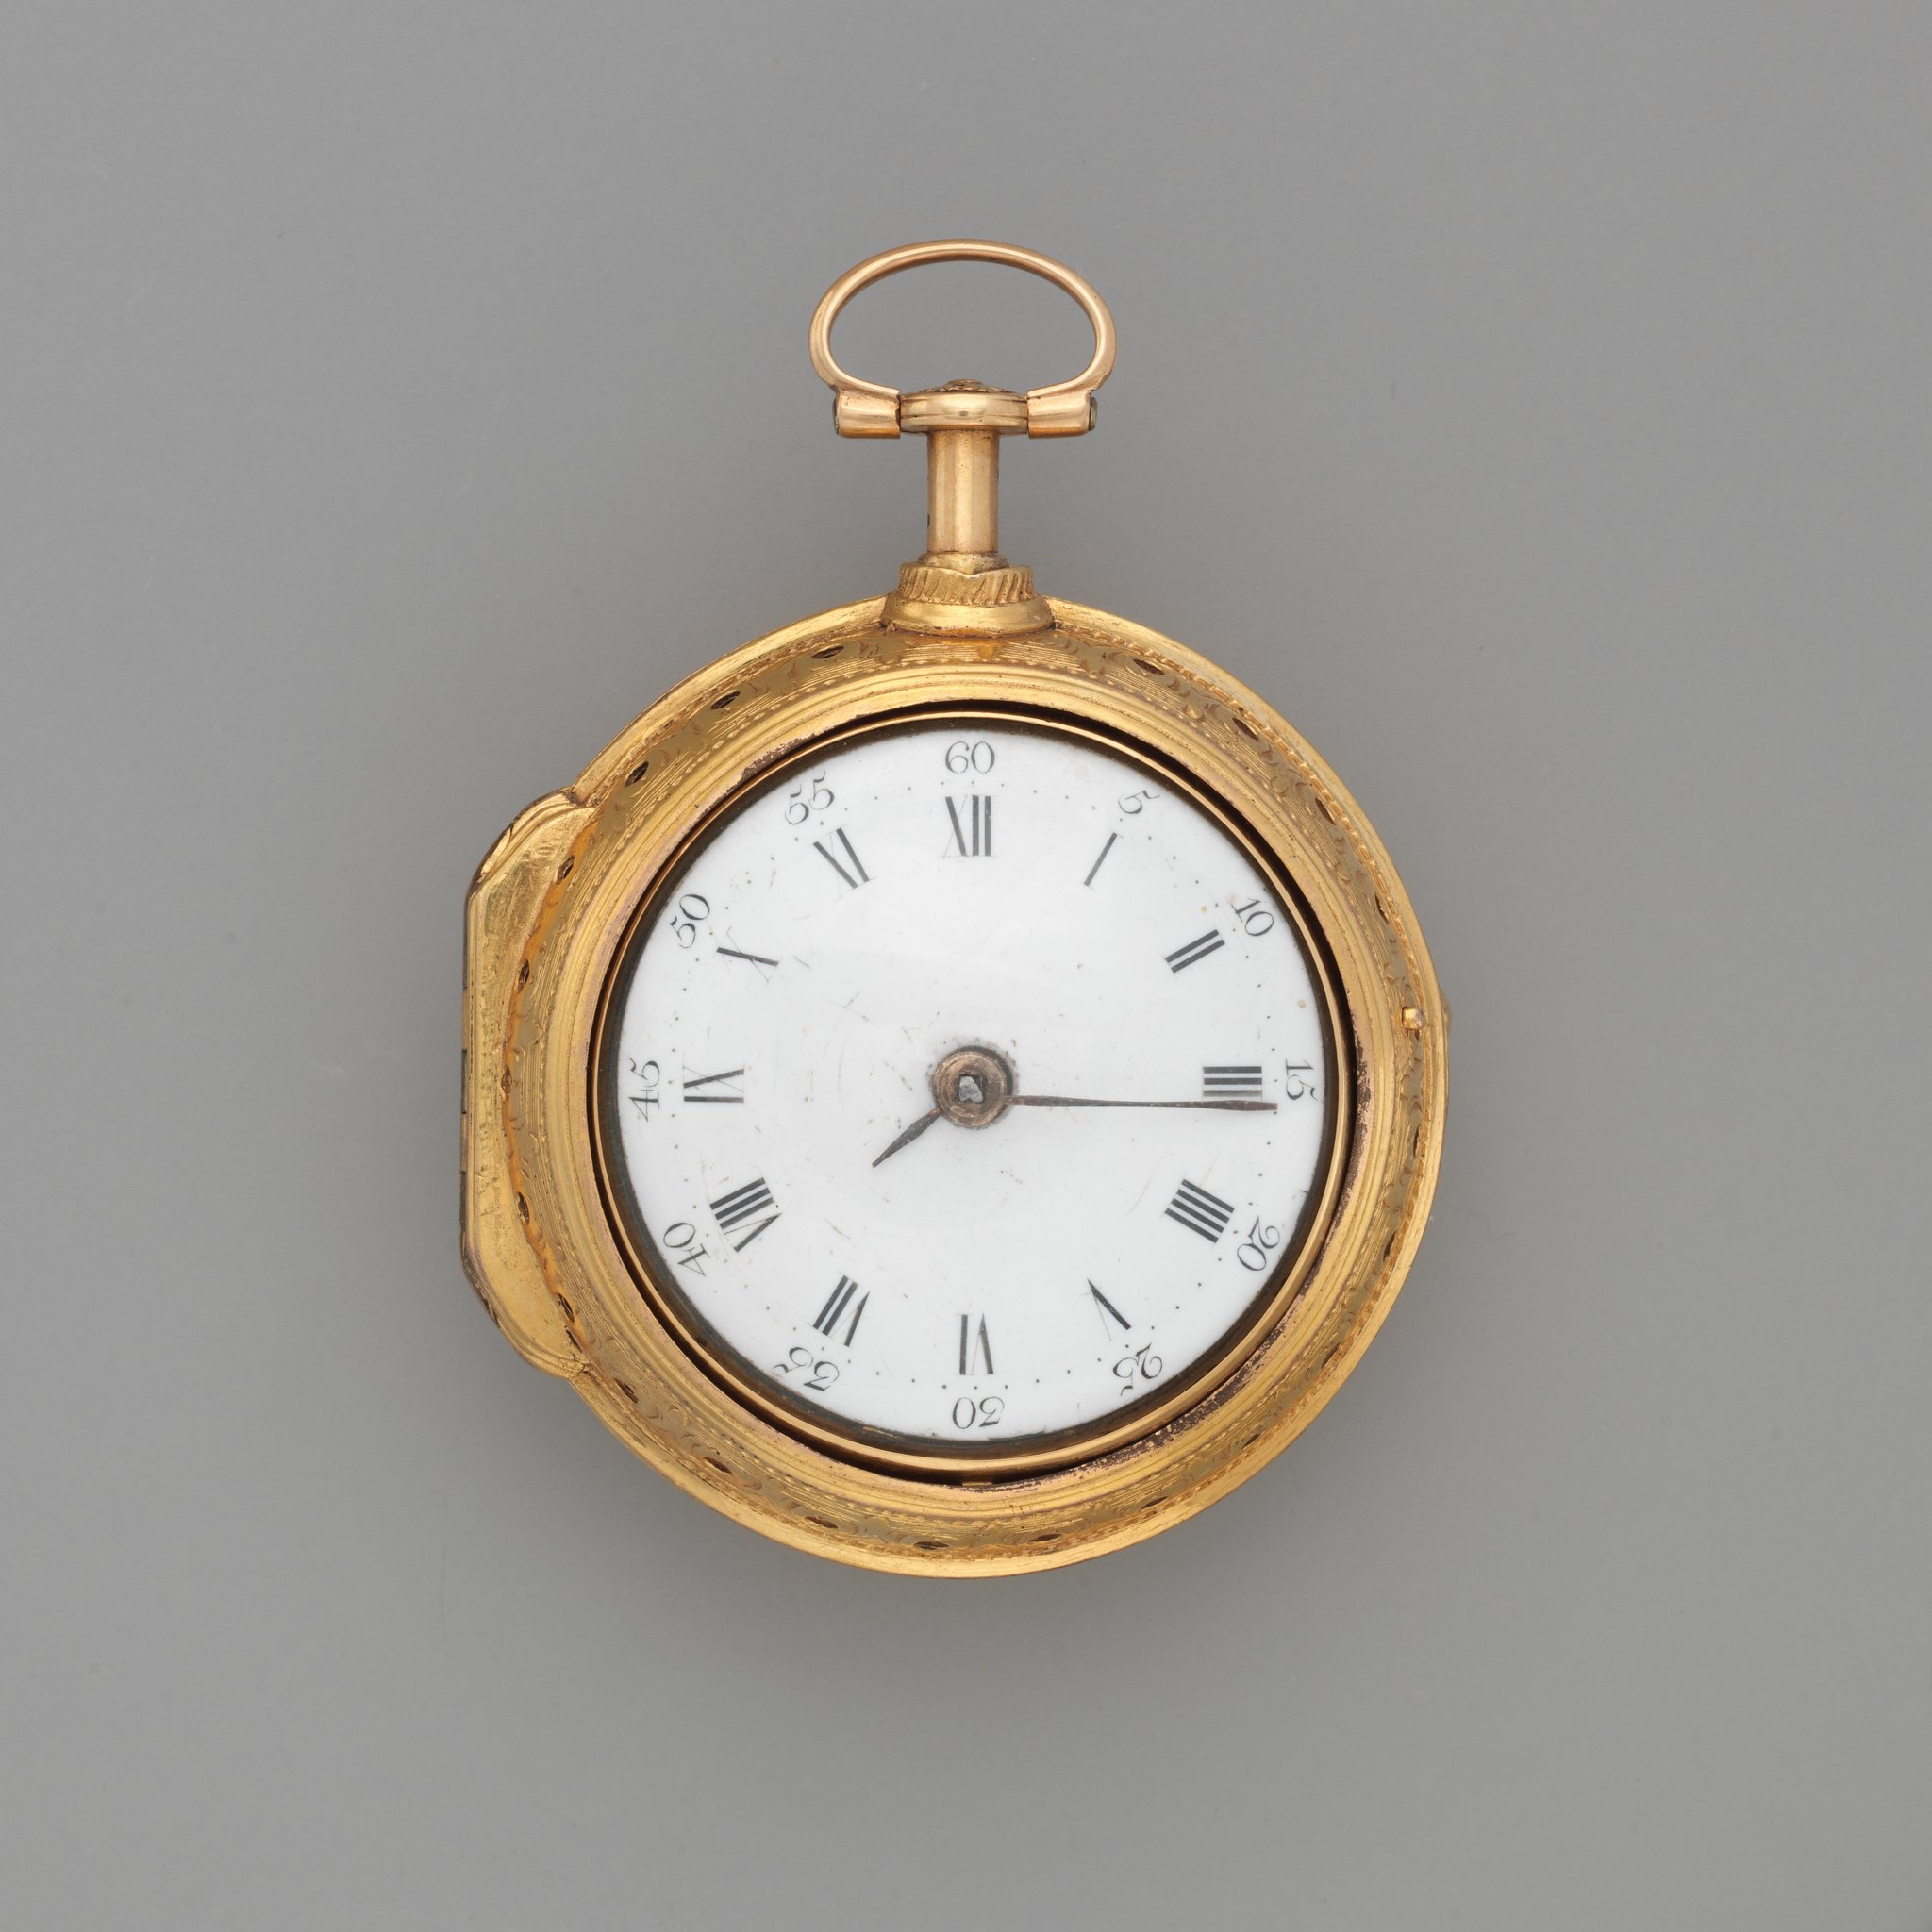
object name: pair case clock watch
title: Pair-case clock-watch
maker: charles cabrier ii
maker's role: maker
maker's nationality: british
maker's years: 1719-1776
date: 1740-1760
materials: enamel, gold